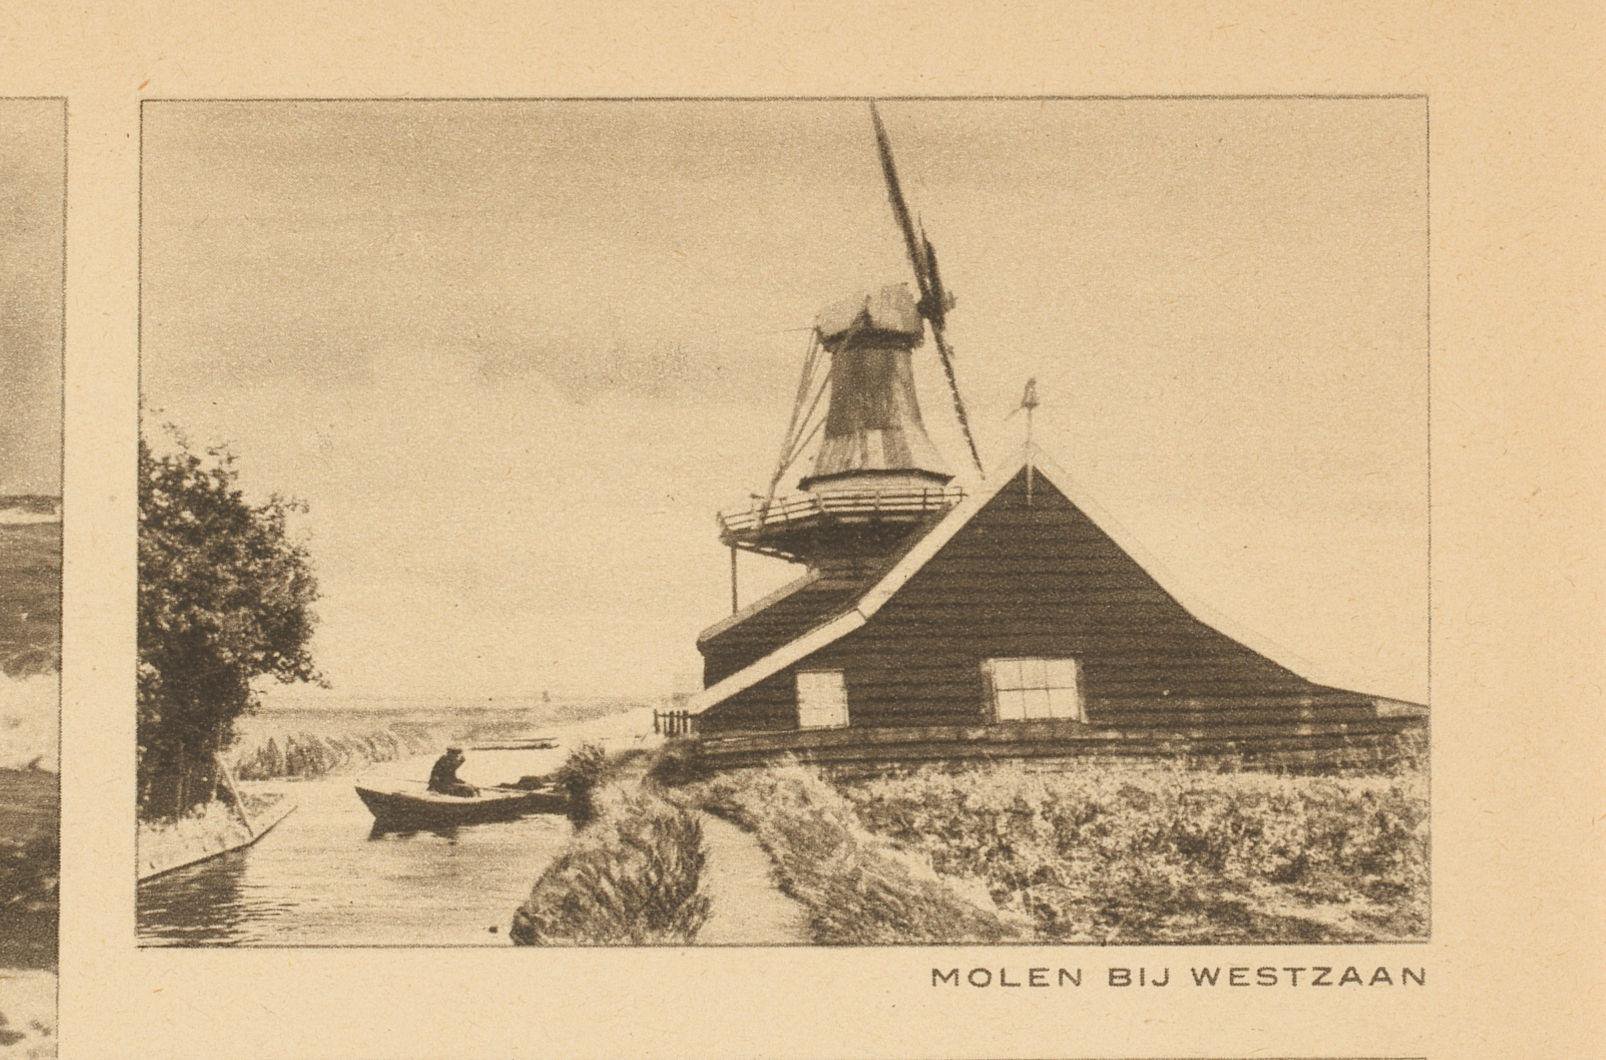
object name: album leaf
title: Gezicht op een molen bij Westzaan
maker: Anonymous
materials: paper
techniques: rotogravure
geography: westzaan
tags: windmill in landscape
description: Deze prent maakt deel uit van een album.